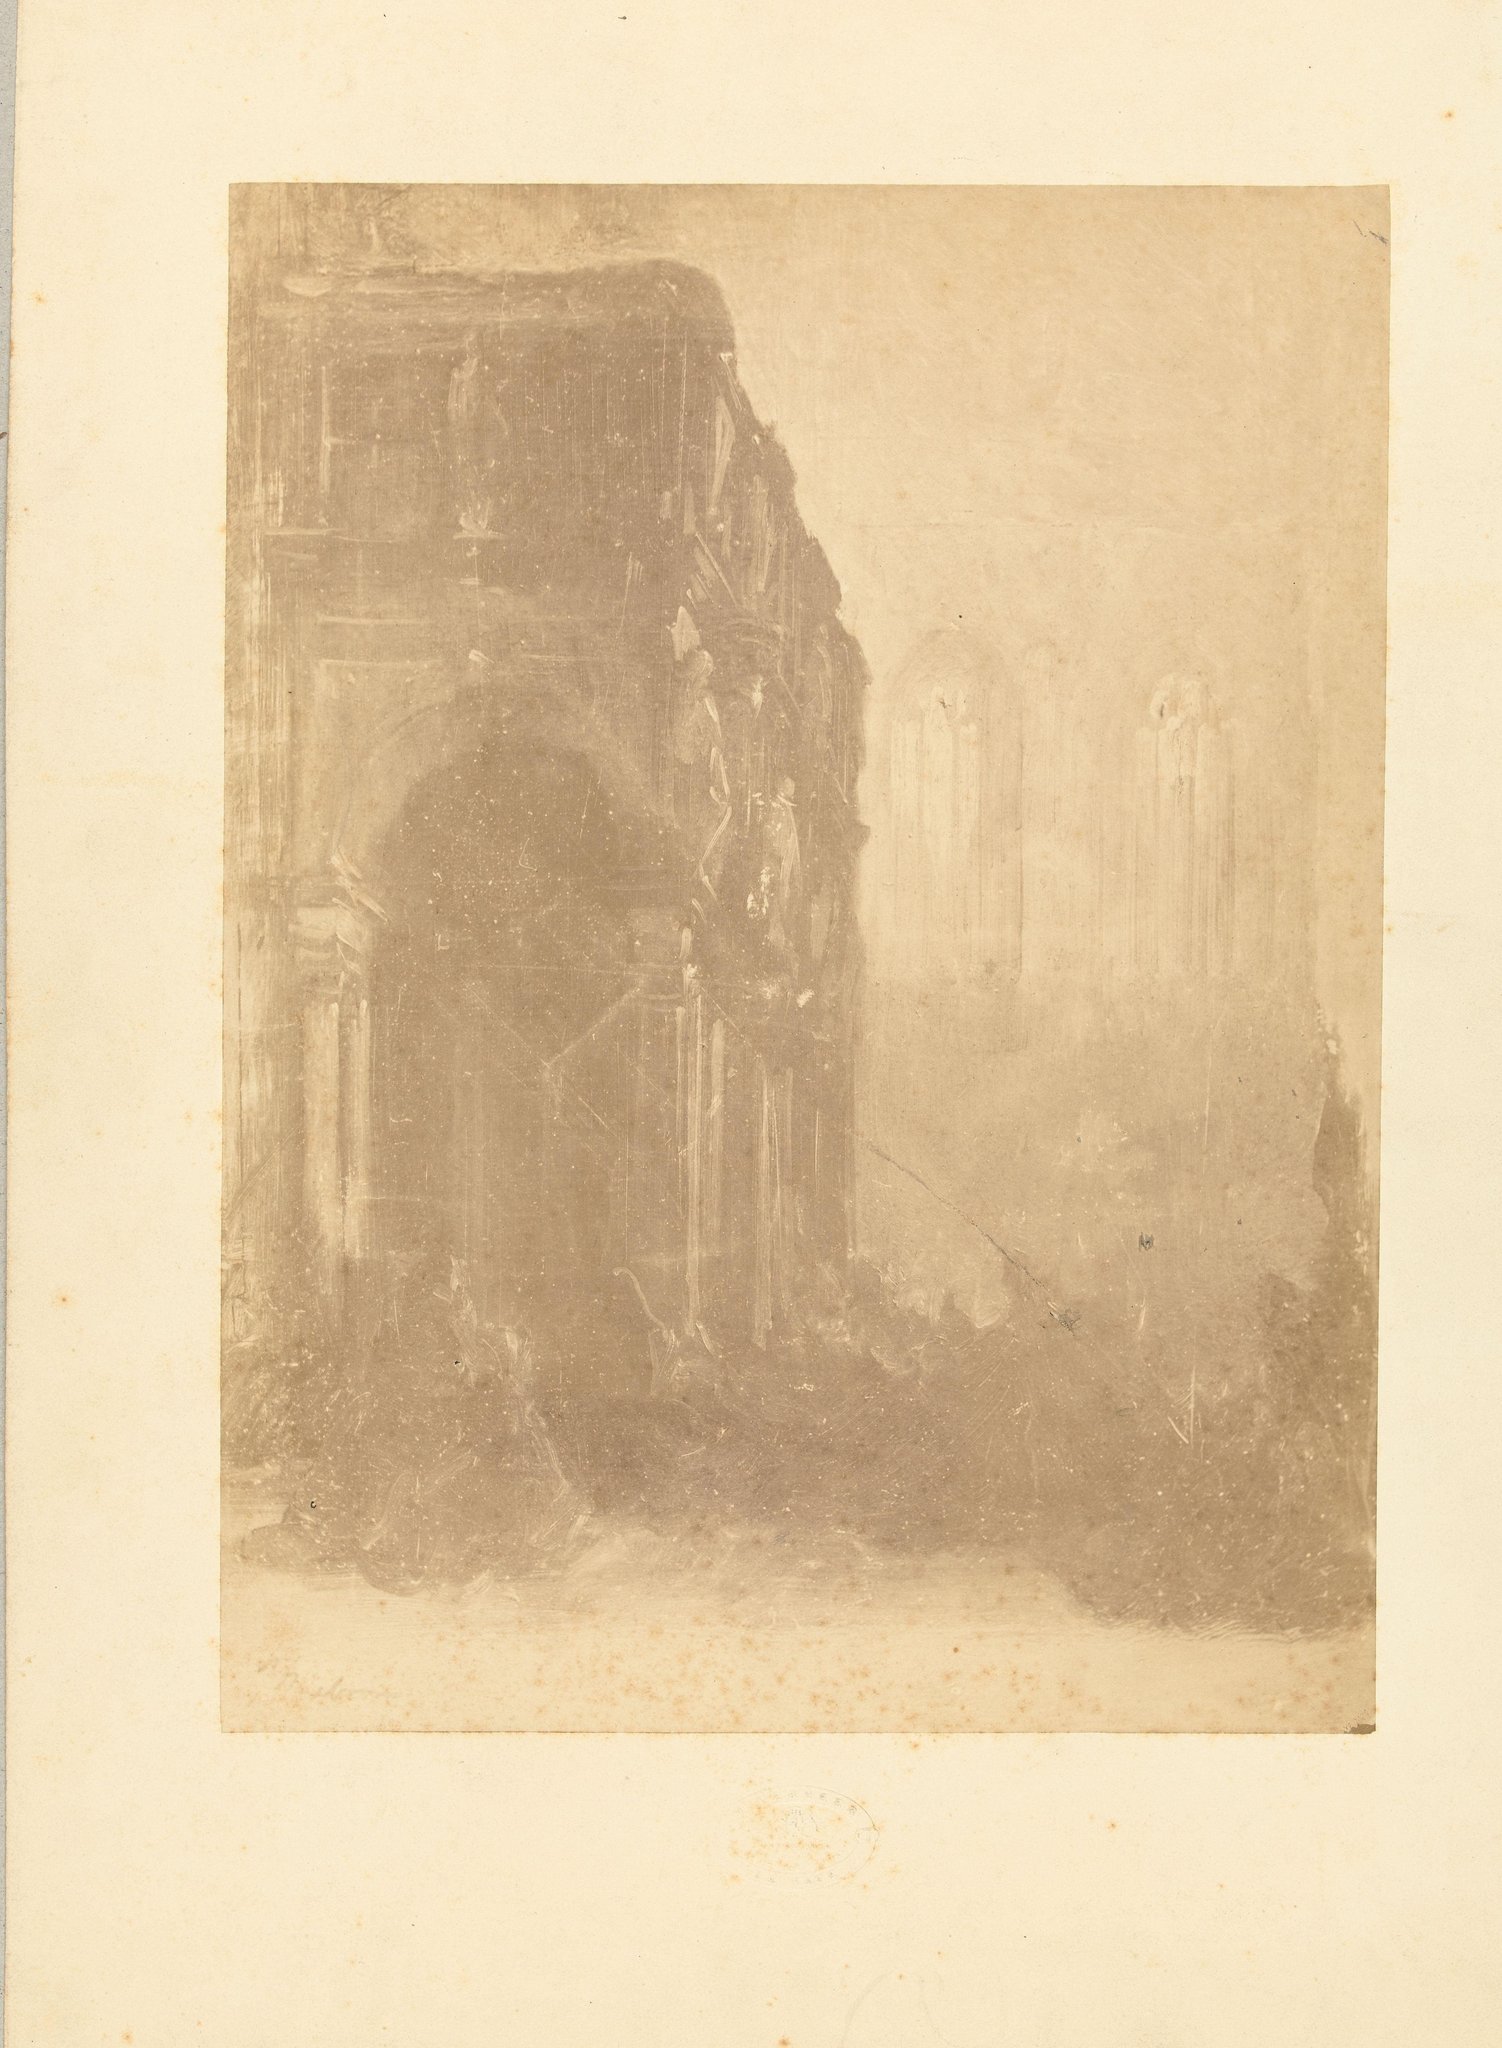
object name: photograph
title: Schilderij van balustrade door Johannes Bosboom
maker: maurits verveer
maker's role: painter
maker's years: 1817-1903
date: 1857-1895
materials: cardboard, paper, photographic support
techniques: albumen print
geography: the hague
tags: picture, painting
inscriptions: name: ‘M. Verveer La Haye’